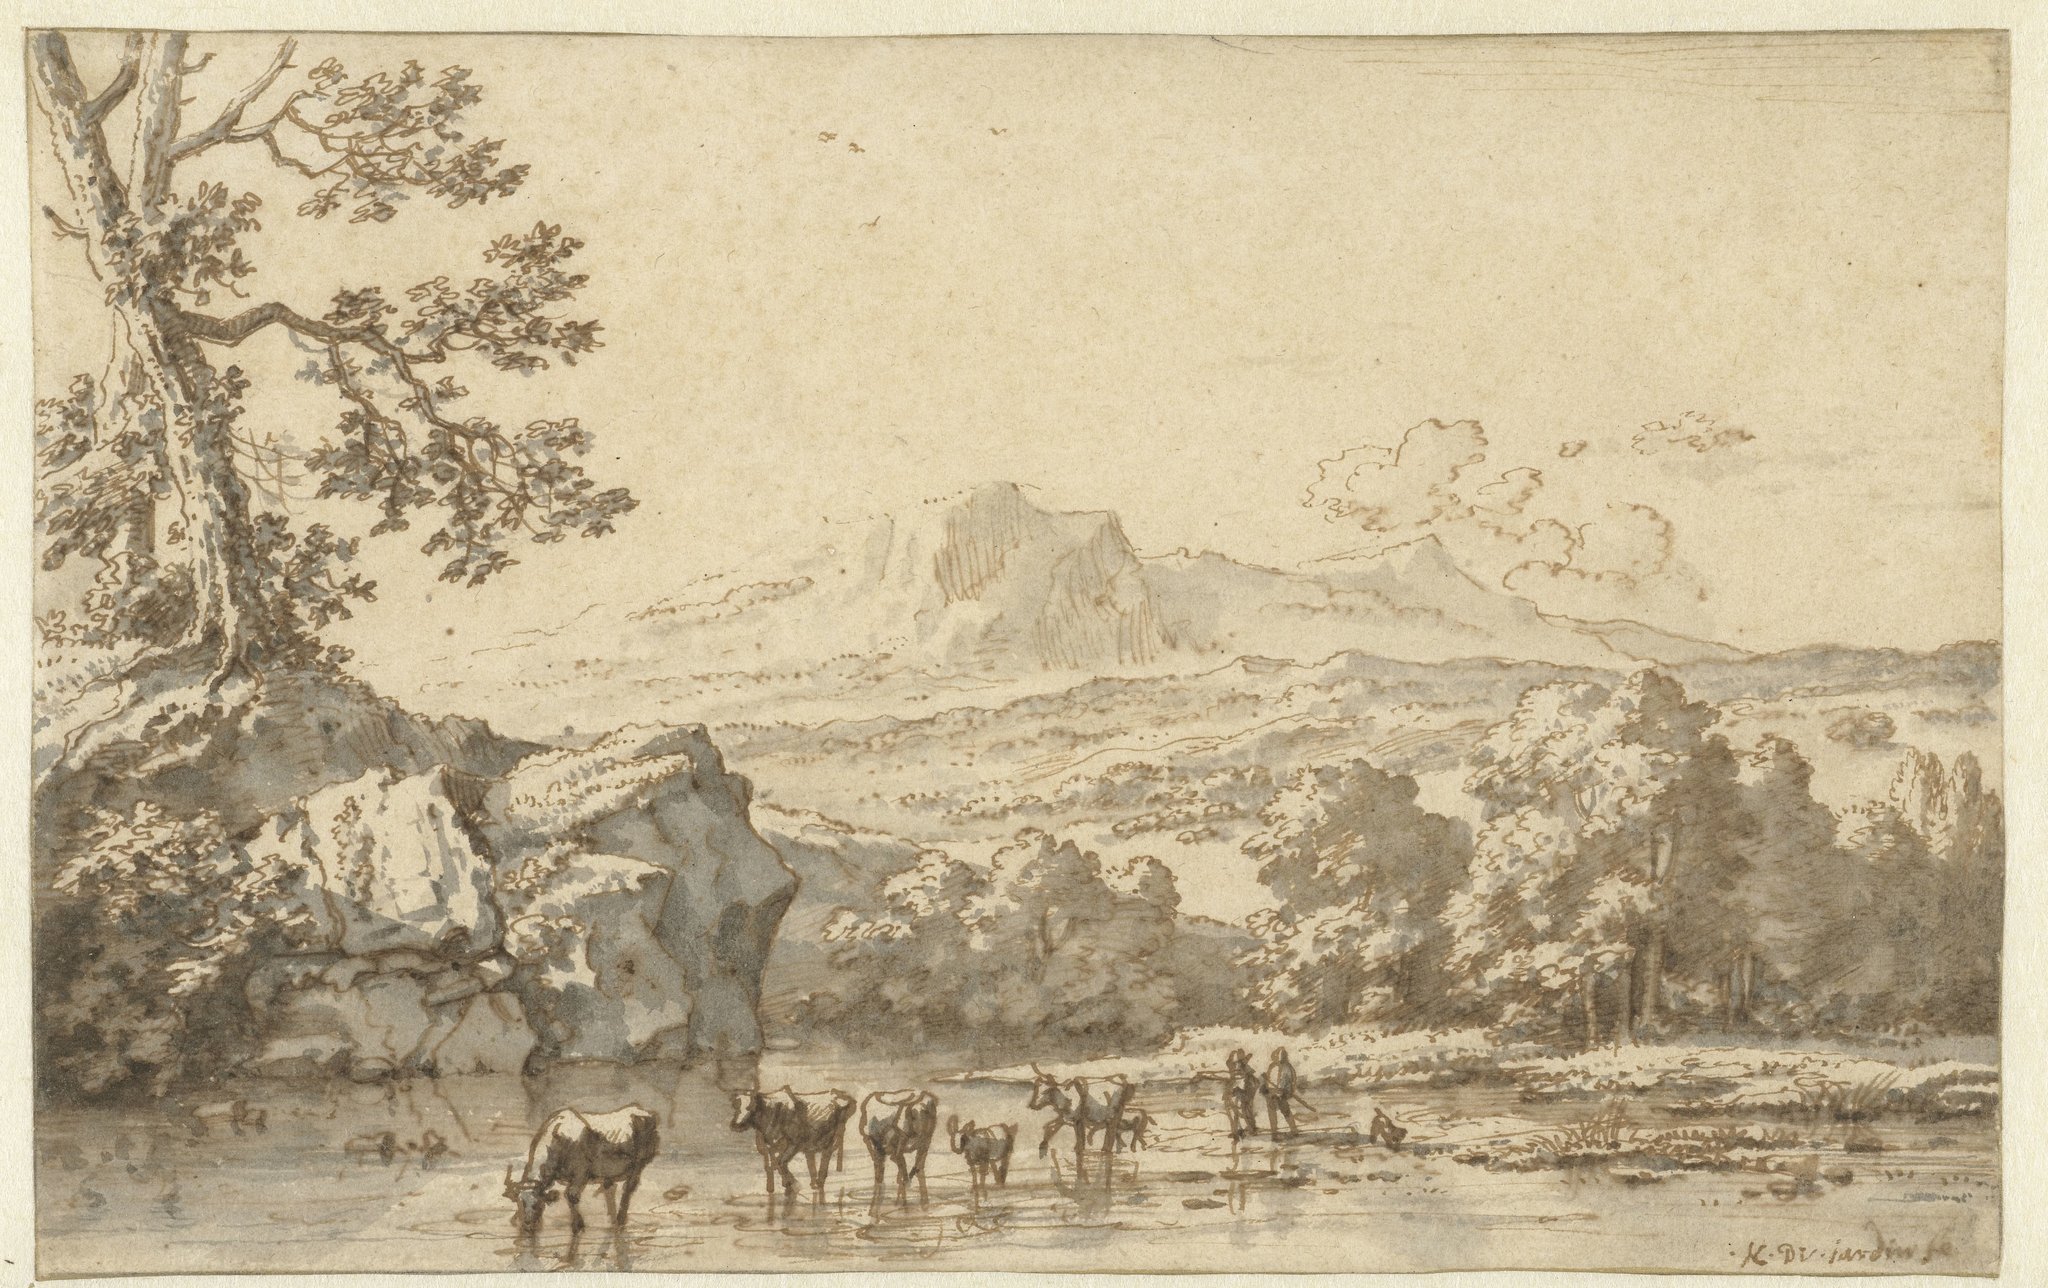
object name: drawing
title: Herders met vee bij een rivier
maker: karel du jardin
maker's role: draughtsman, painter, print maker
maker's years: 1626-1678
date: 1650-1659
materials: paper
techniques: brush, pen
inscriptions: signature: ‘K.du,jardin fe’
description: Herders met dieren die door ondiep water lopen in een zuidelijk landschap. Op de achtergrond heuvels.